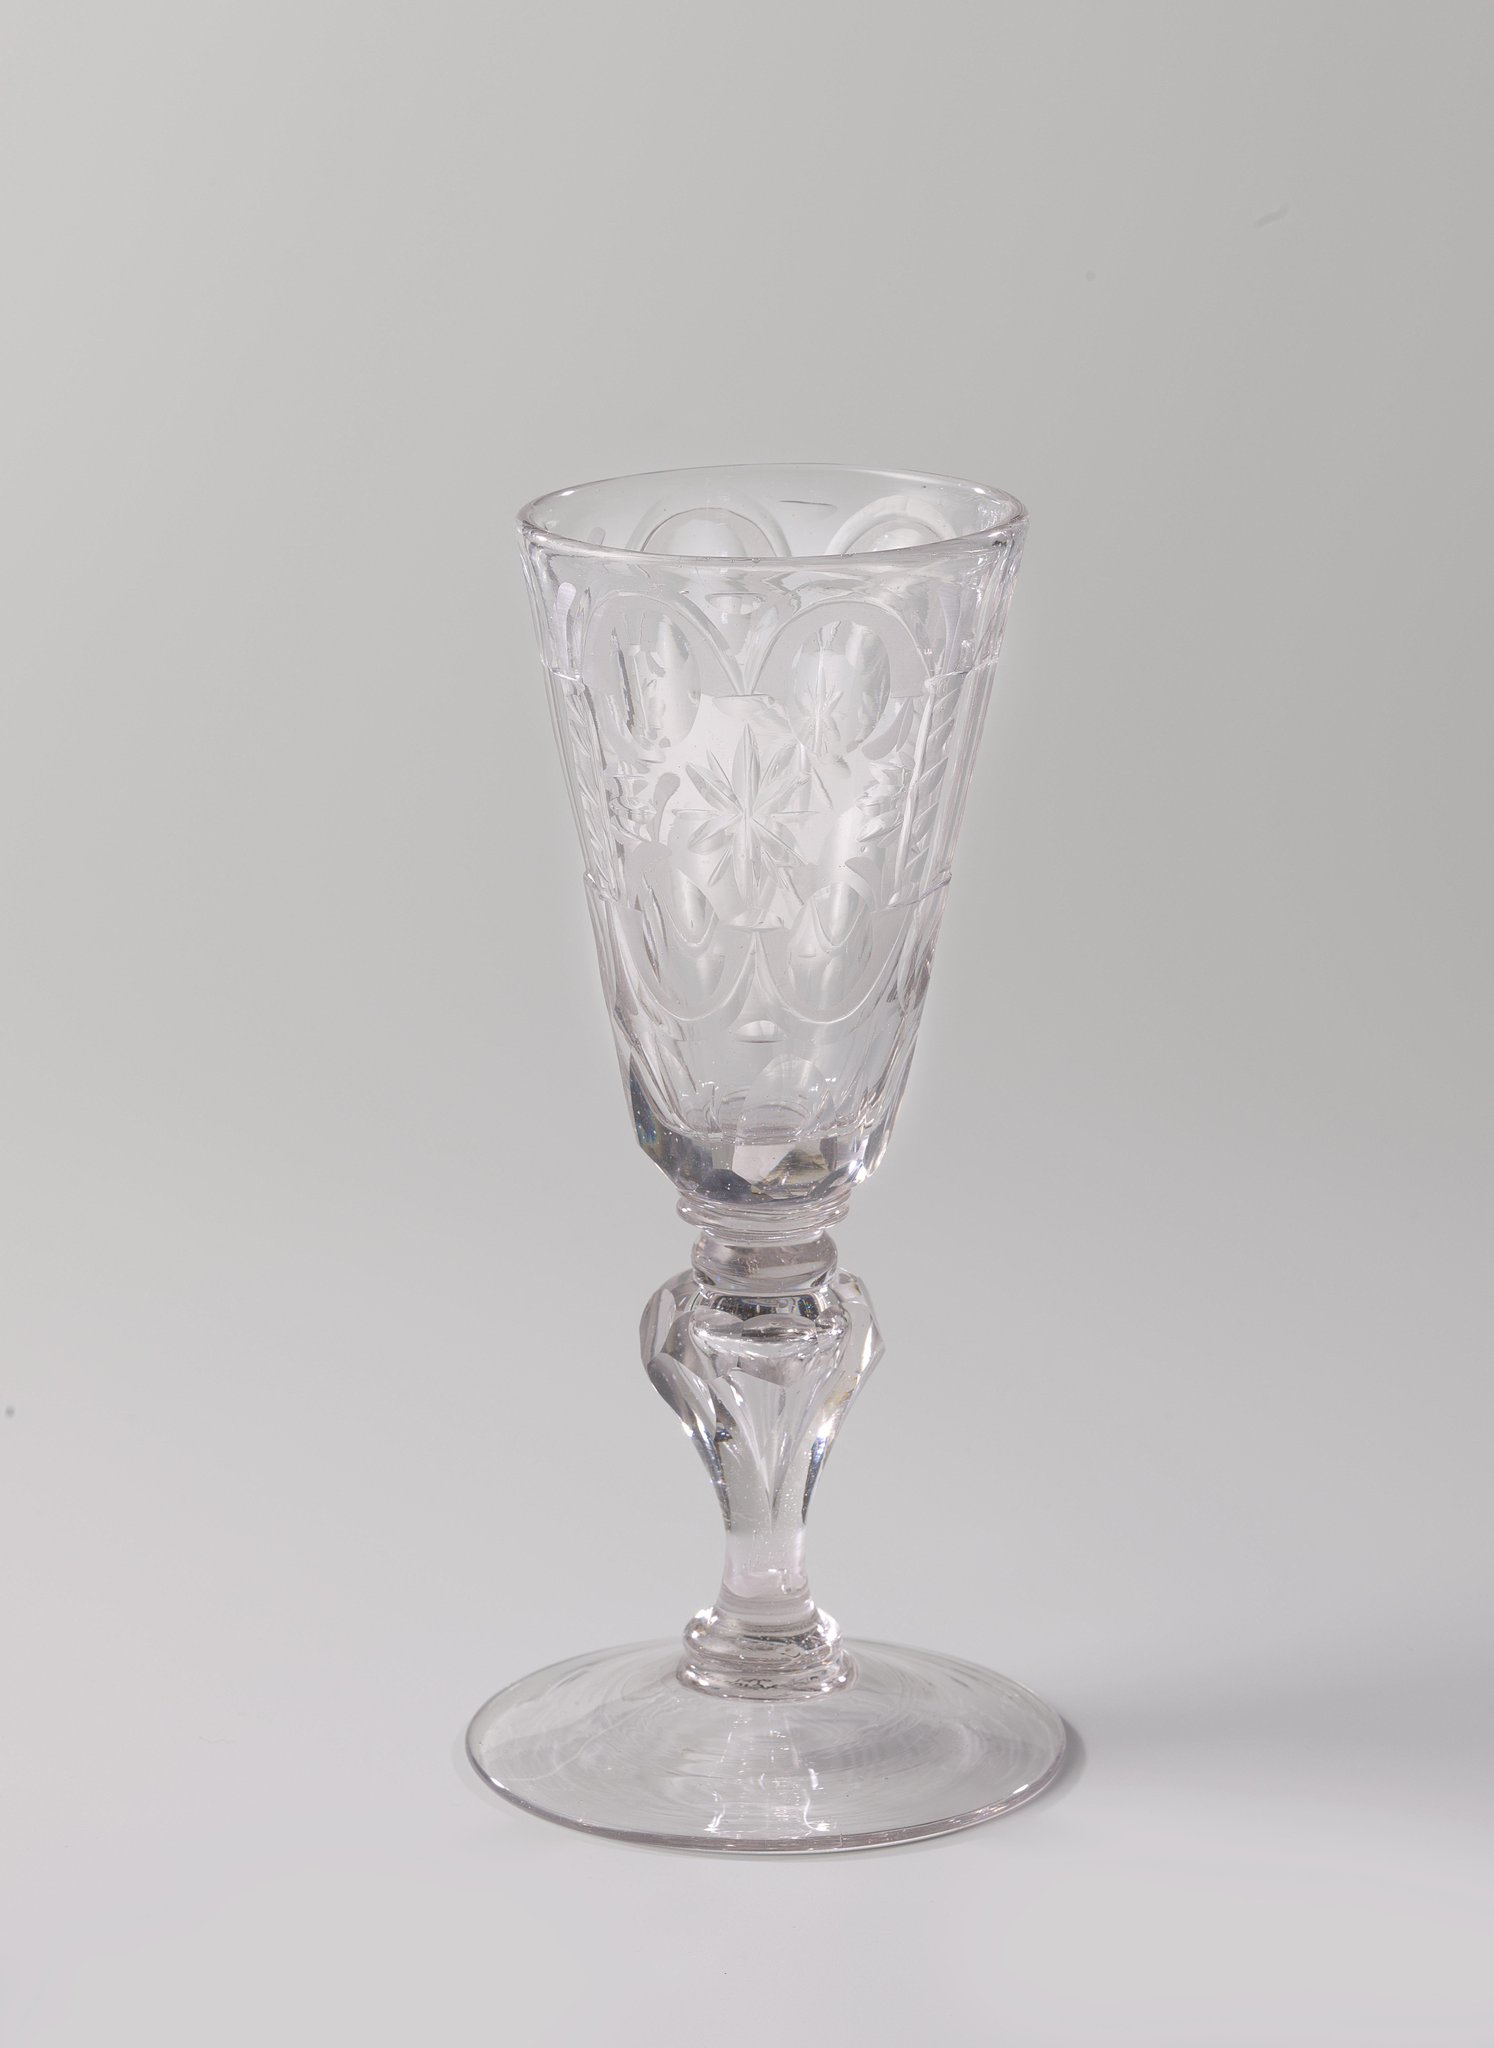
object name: goblet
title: Kelkglas met twee rozetten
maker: Anonymous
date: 1725-1775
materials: glass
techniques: glassblowing, grinding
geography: bohemia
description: Conische voet. Balusterstam met ongeslepen knoop. Op de kelk twee gegraveerde rozetten met zes bladeren.